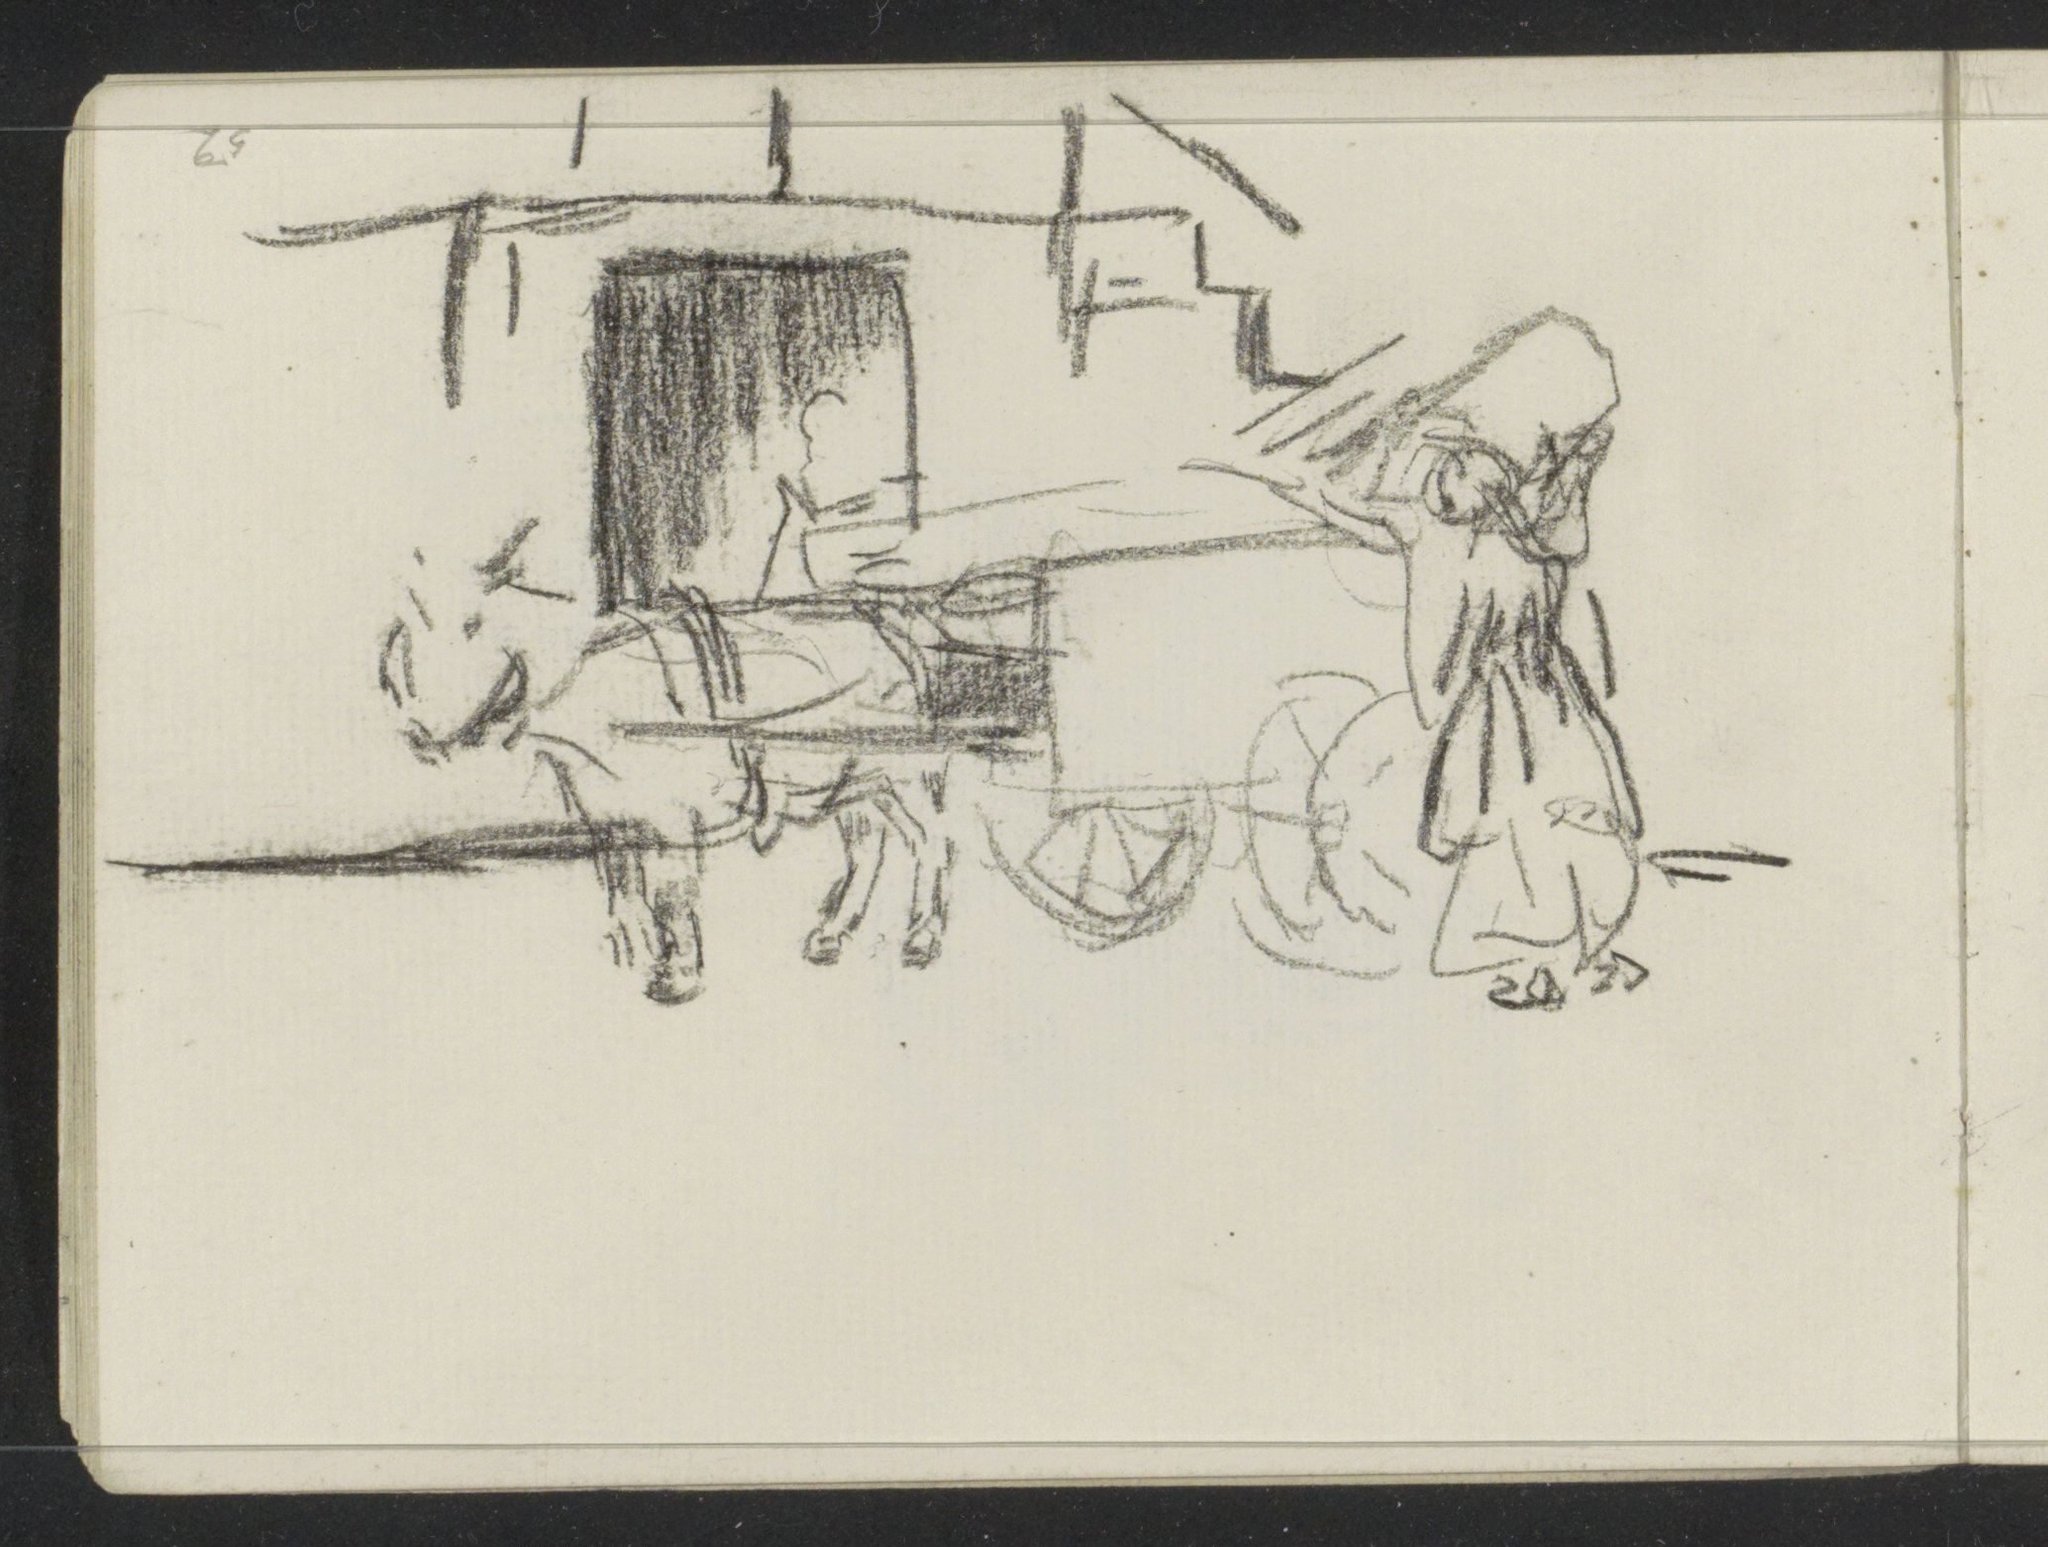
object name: sketchbook leaf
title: Vrouw bij een ezelkar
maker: isaac israels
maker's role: draughtsman, painter, print maker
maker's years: 1865-1934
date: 1886-1934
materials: chalk, paper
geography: amsterdam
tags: adult woman, carrying something, ass, donkey, two-wheeled vehicle drawn by one animal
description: De kar staat voor een geveltrap. De vrouw heeft vracht in haar handen. Blad 7 verso uit schetsboek LXIV met 29 bladen.